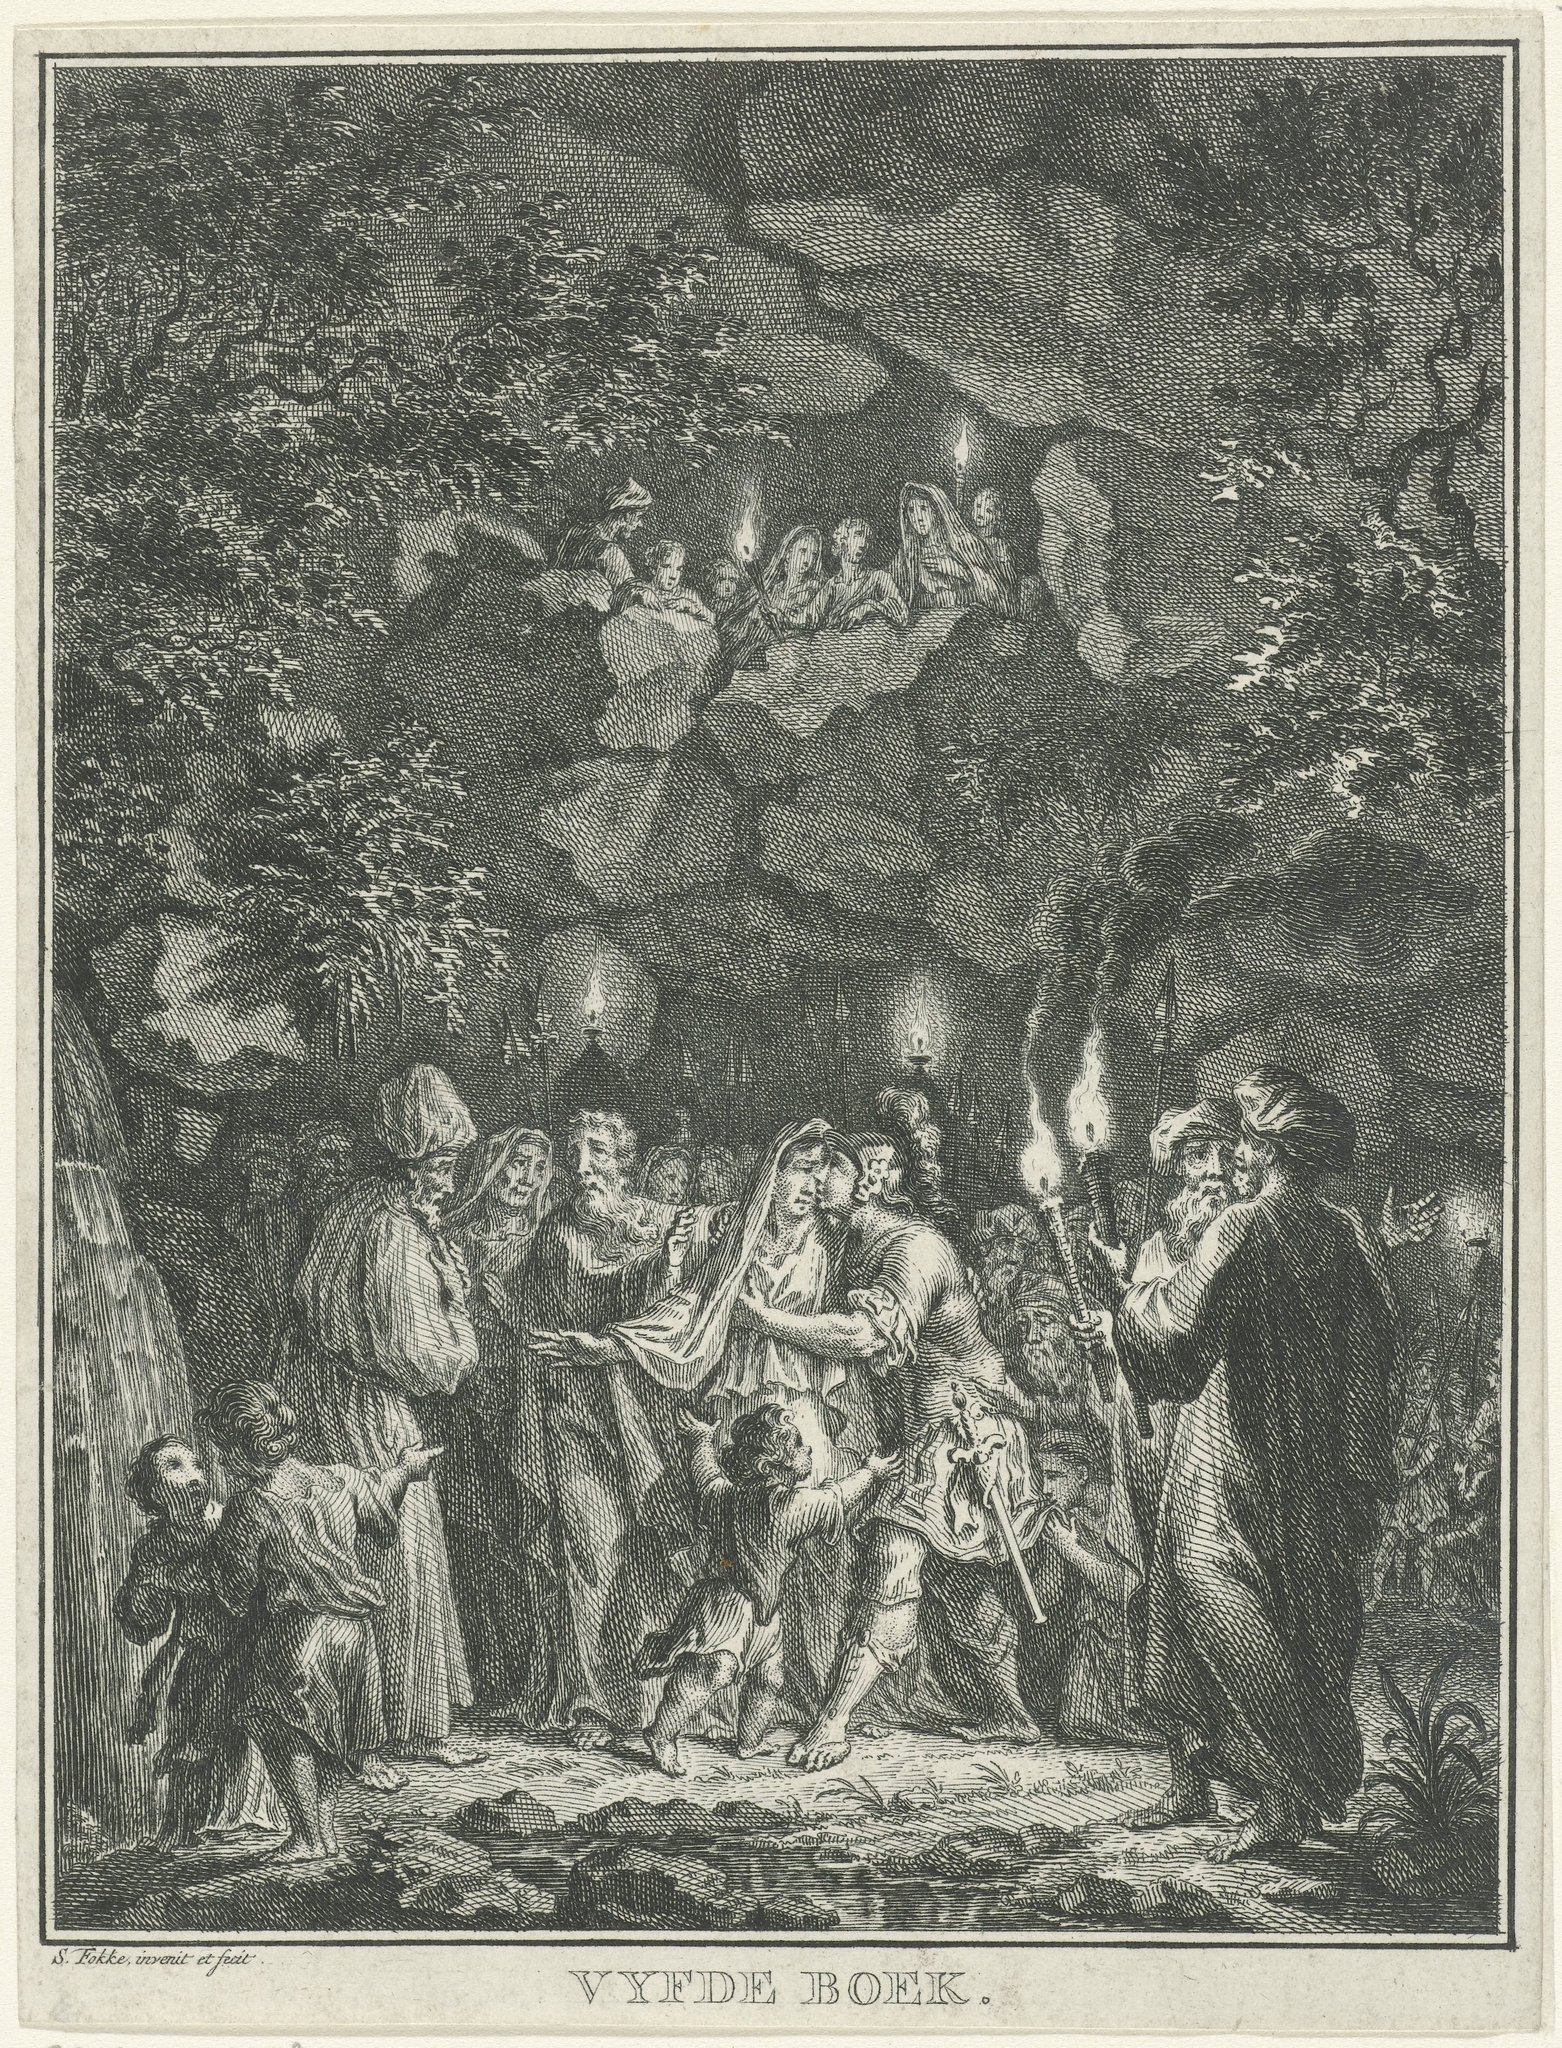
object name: print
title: David en Saul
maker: simon fokke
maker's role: draughtsman, print maker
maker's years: 1712-1784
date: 1766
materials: paper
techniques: etching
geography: amsterdam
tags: david's flight from saul after his marriage with michal (1 samuel 19)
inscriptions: collector's mark: Lugt 2228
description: Bij fakkellicht en omringd door omstanders neemt David in legerkleding afscheid van zijn treurende eerste vrouw Michal. De prent maakt deel uit van een serie over het verhaal van David en Saul.